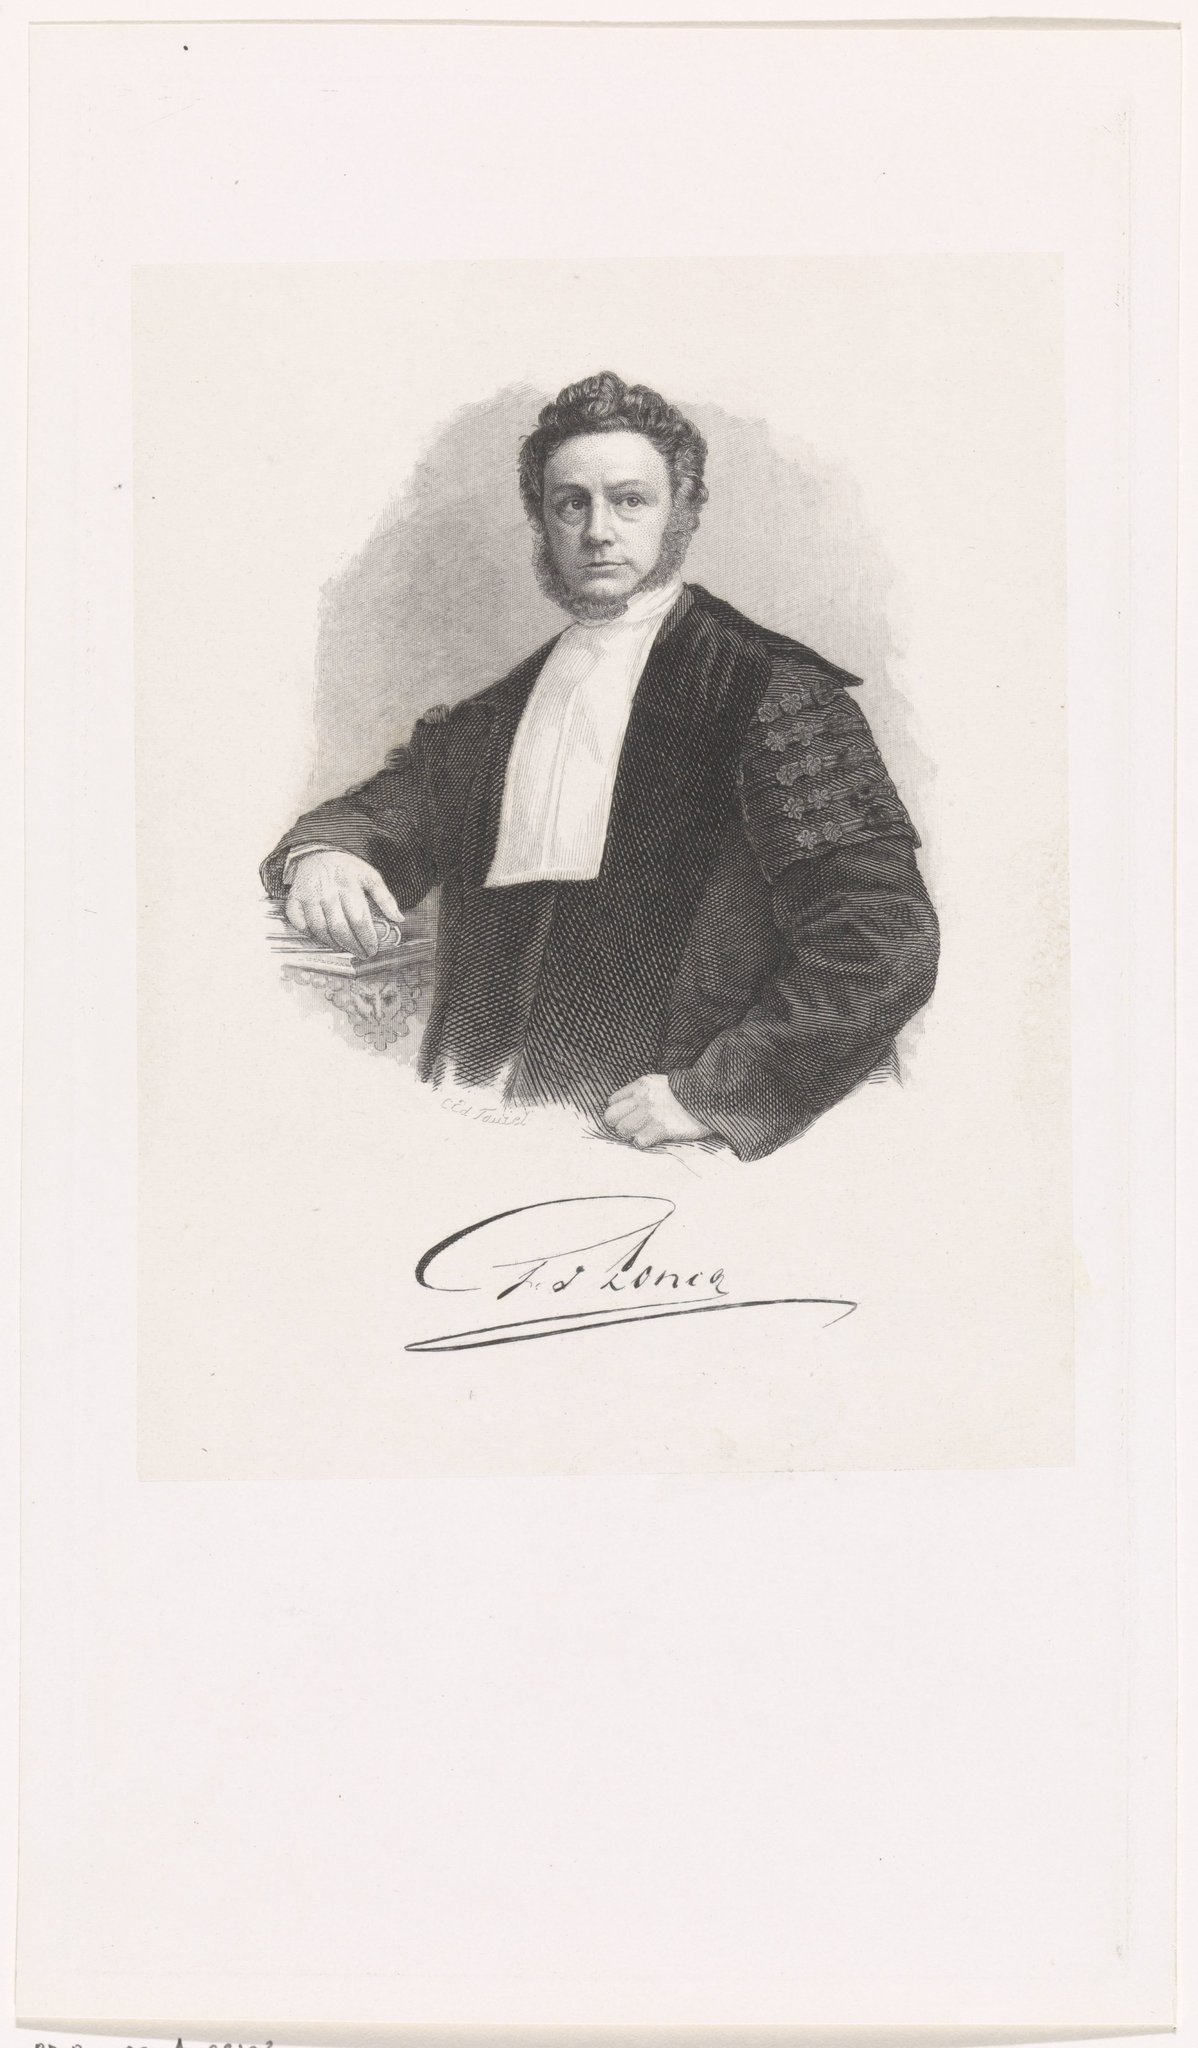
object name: print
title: Portret van de medicus Gozewijn Jan Loncq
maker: edouard taurel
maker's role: draughtsman, print maker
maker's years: 1824-1892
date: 1863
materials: paper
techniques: engraving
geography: amsterdam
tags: utrecht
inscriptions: collector's mark: Lugt 2228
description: Prent ook gebruikt in: Utrechtsche Studenten Almanak, 1863.